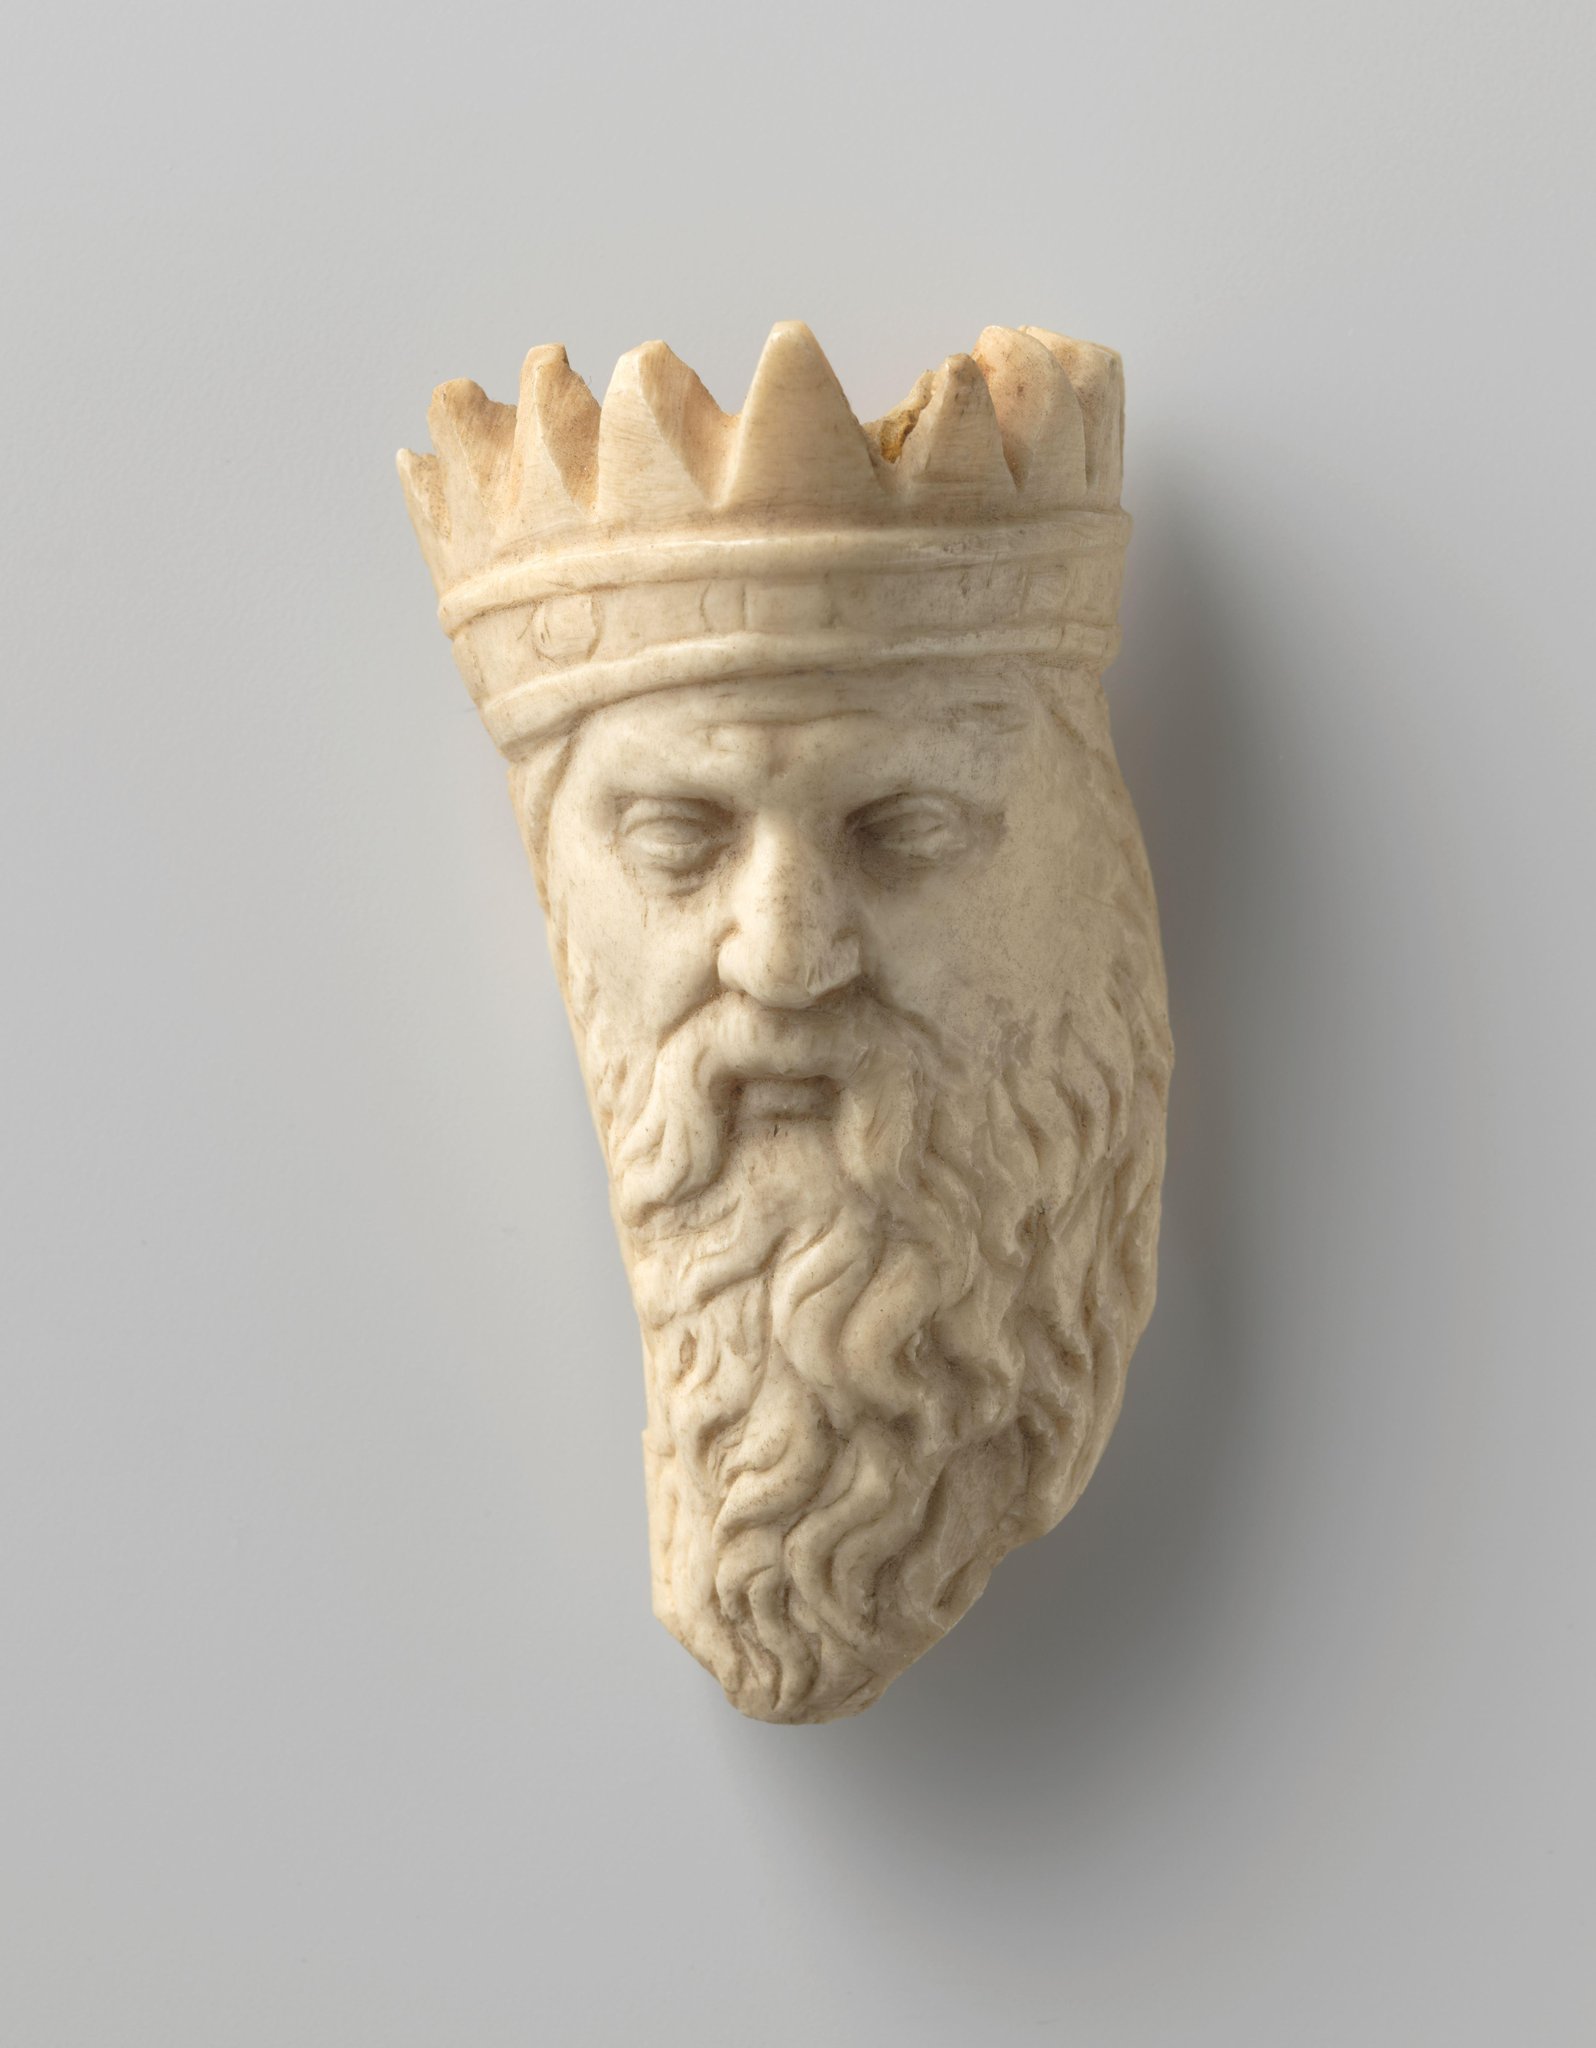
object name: fragment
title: Mannenhoofd van ivoor met kroon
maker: Anonymous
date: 1600-1699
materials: ivory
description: Mannenhoofd van ivoor met kroon (David?). Fragment.